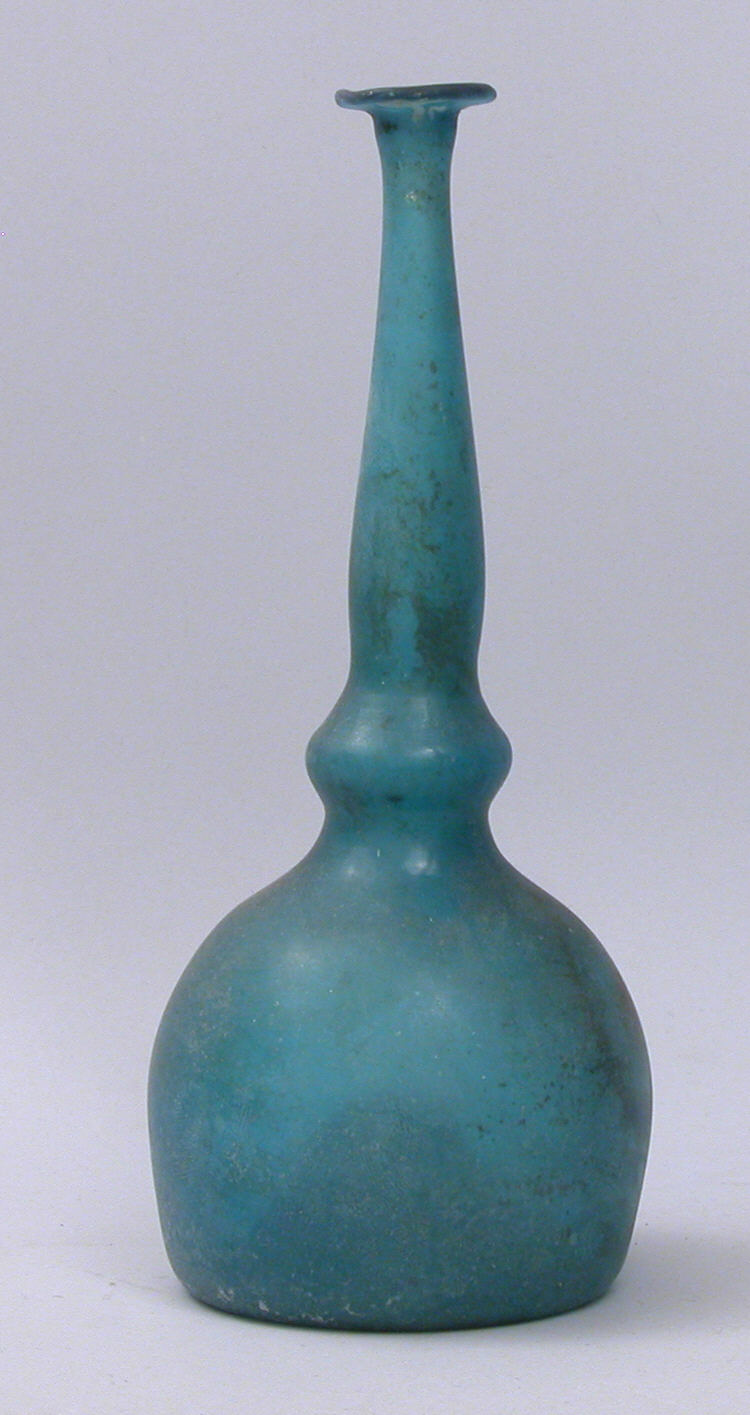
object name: bottle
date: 1701-1900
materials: glass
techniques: glassblowing, tooling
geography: iran